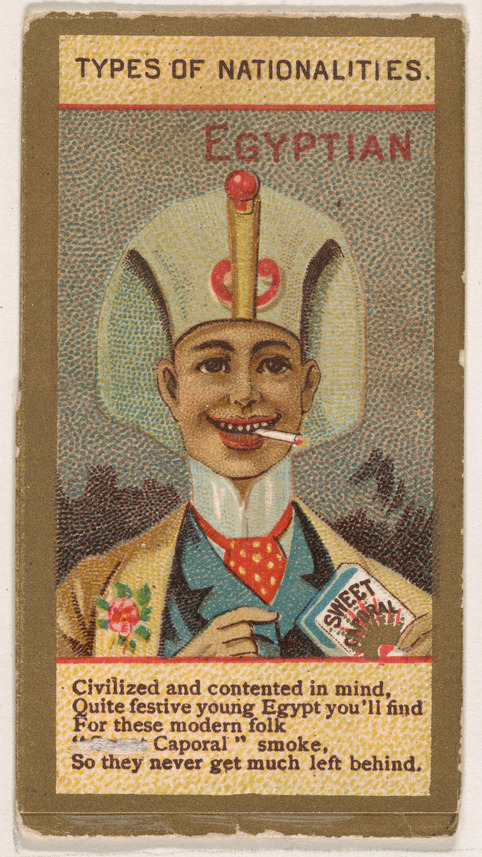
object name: print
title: Egyptian, from Types of Nationalities (N240) issued by Kinney Bros.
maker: kinney brothers tobacco company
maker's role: publisher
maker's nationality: american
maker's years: 1869-2011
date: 1890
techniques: color lithograph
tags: men,smoking